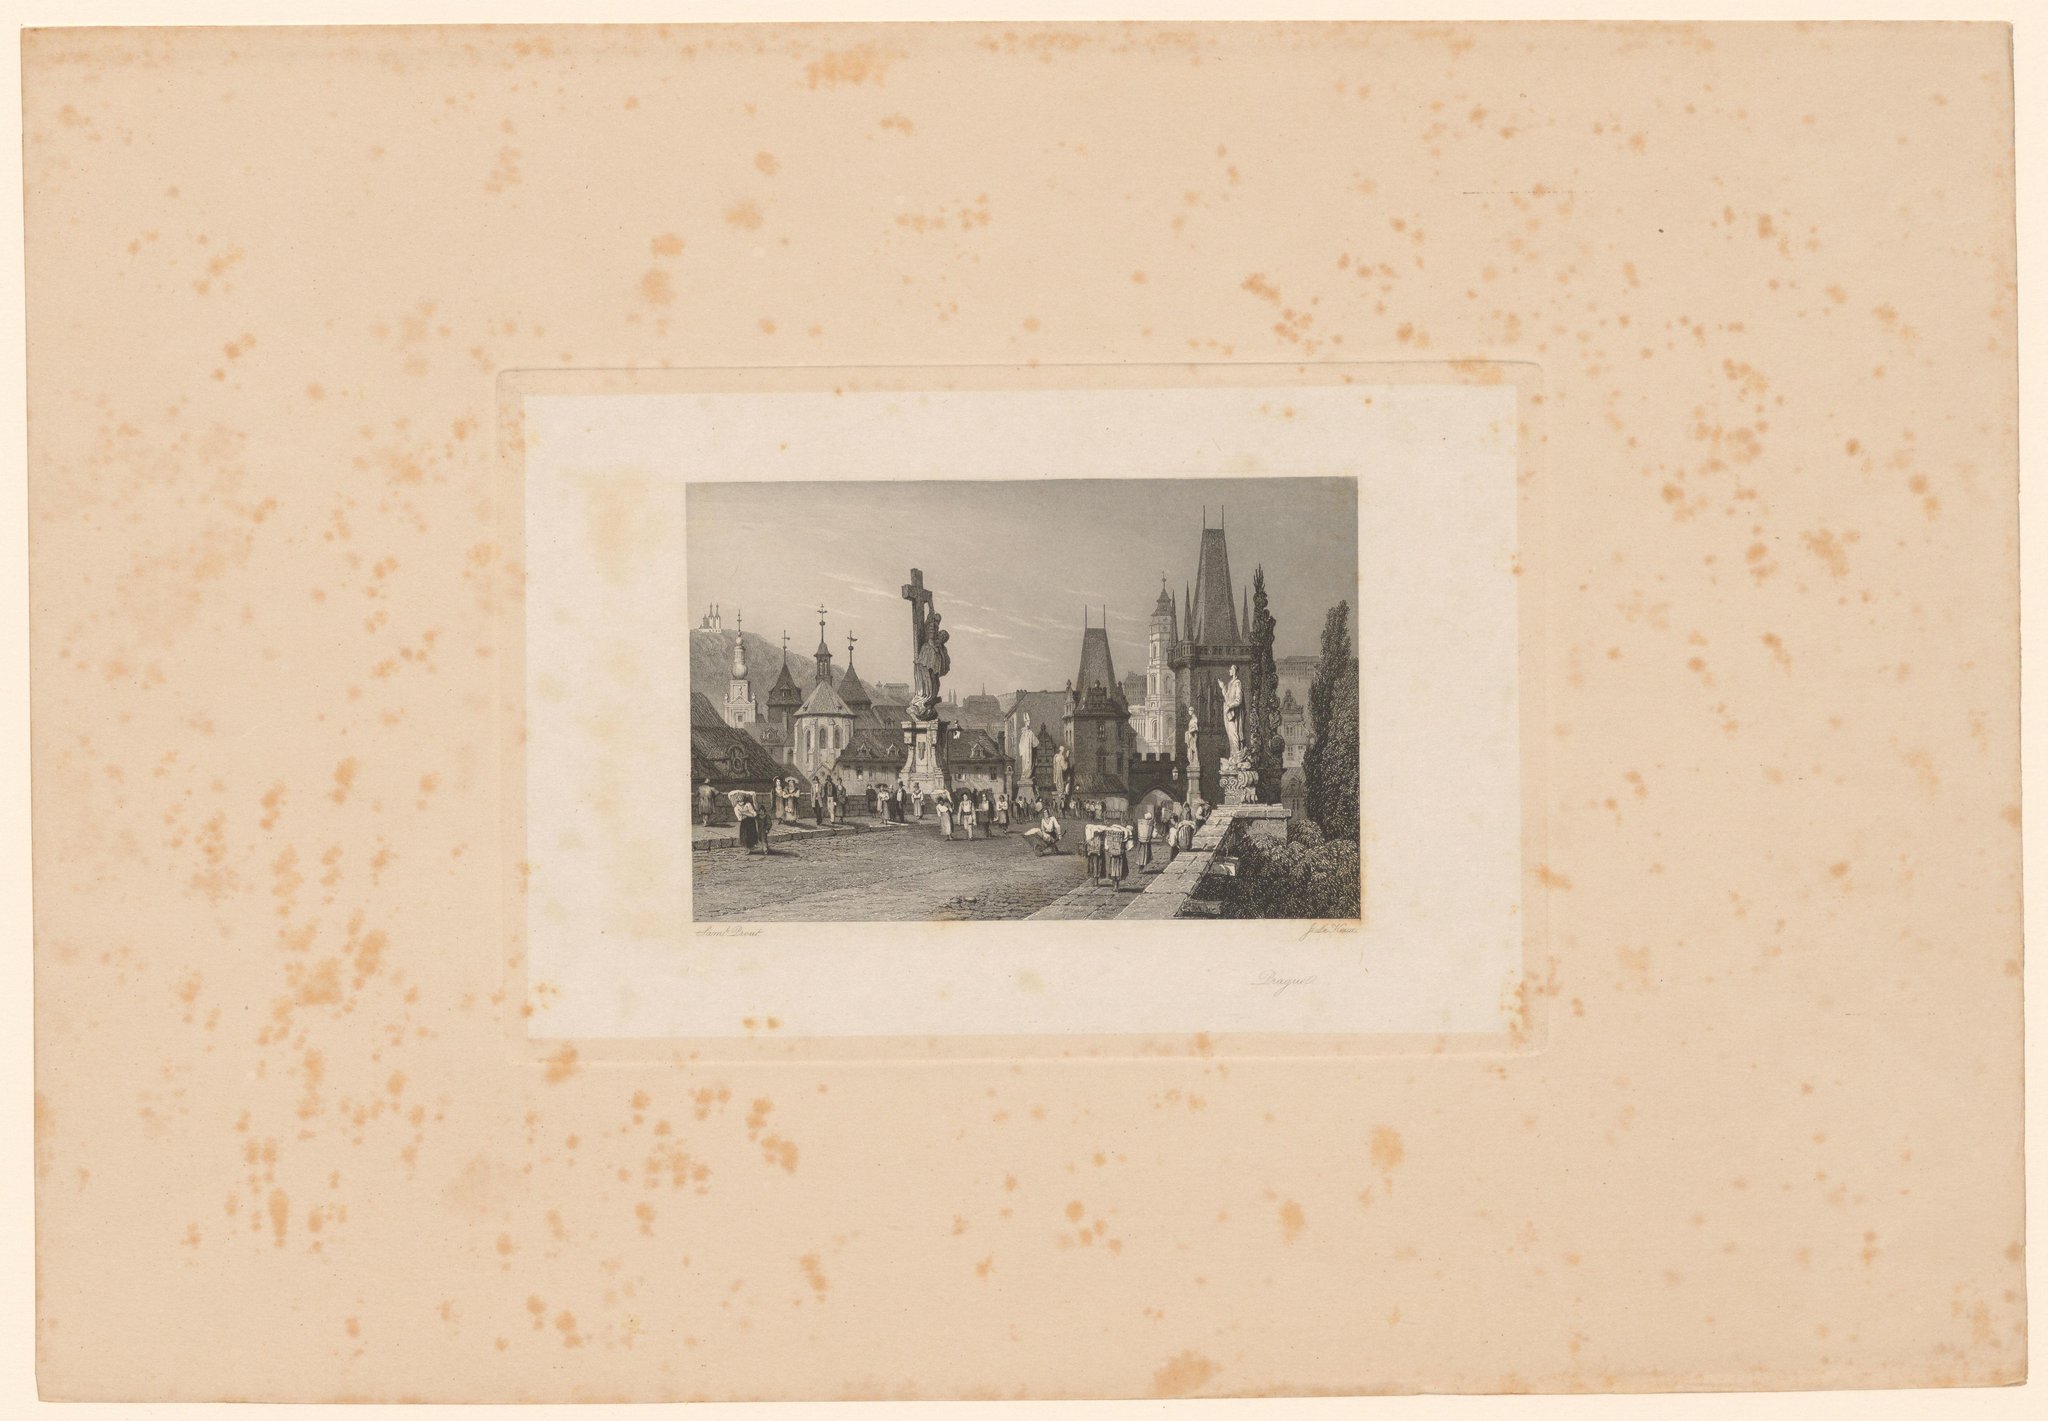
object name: print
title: Prague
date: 1793-1846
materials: paper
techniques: engraving, etching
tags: bridge, prospect of city, town panorama, silhouette of city (+ city(-scape) with figures, staffage), prague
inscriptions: collector's mark: Lugt 2228